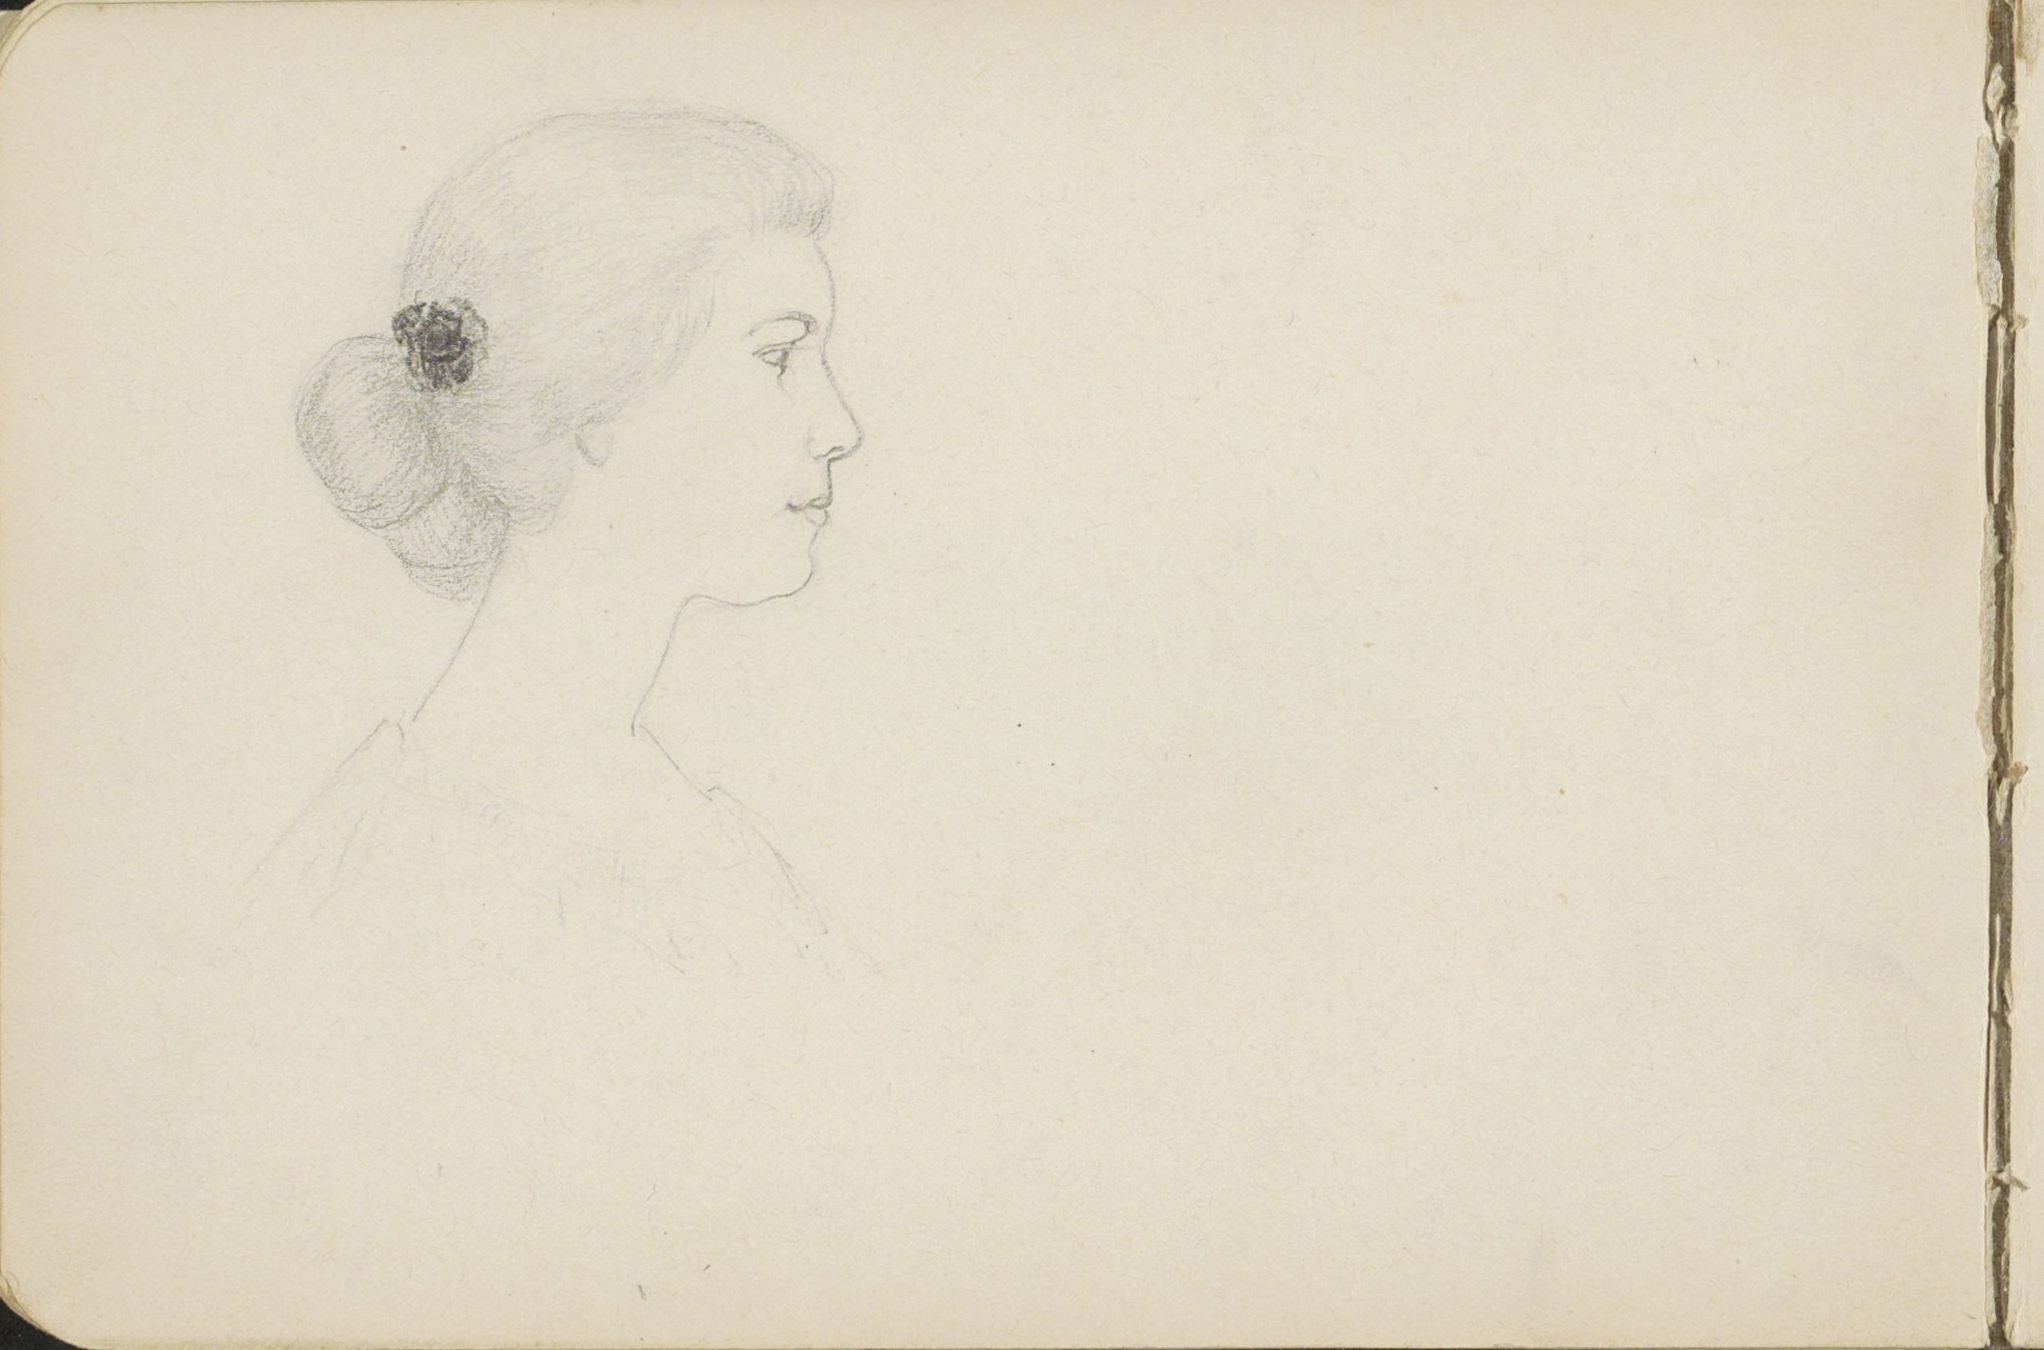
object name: sketchbook leaf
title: Kop van een vrouw met een bloem in haar opgestoken haar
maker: julie de graag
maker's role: draughtsman, print maker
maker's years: 1877-1924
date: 1894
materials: paper, pencil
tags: flowers, head (human), adult woman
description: Blad 8 verso uit een schetsboek met 35 bladen.